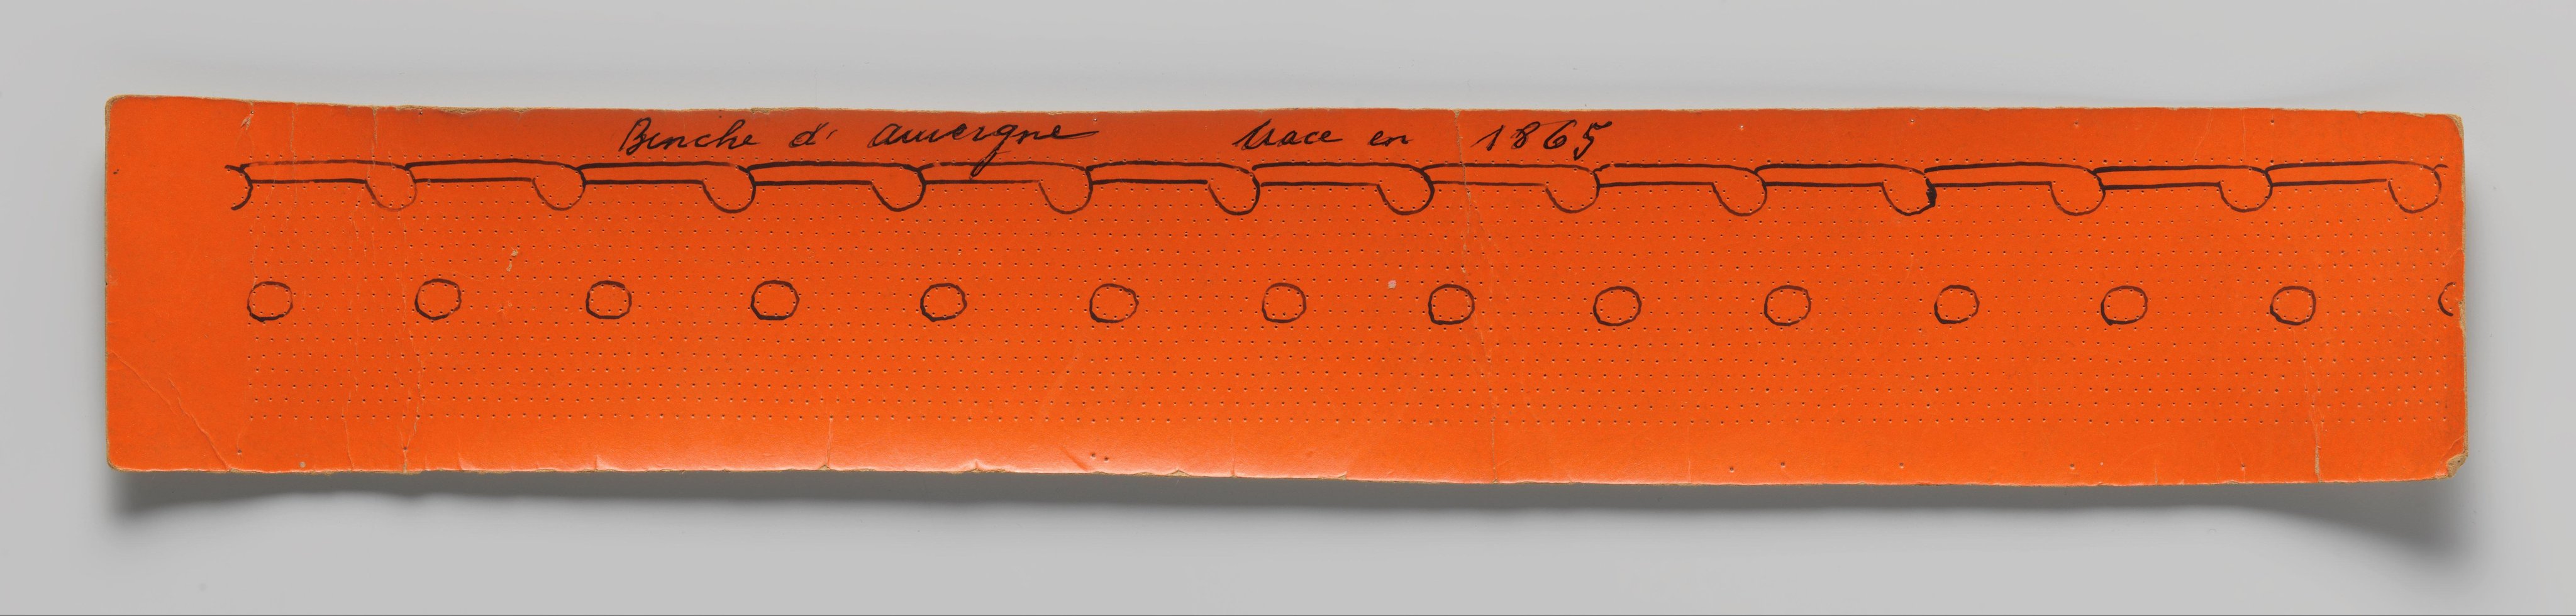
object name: lace pattern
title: Patroon voor een strook kloskant Binche d'Auvergne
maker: Anonymous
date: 1865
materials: cardboard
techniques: drawing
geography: france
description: Patroon voor een strook kloskant op oranje gekleurd karton. Op het patroon staat de handgeschreven tekst: "Binche d'Auvergne; [....] en 1865".